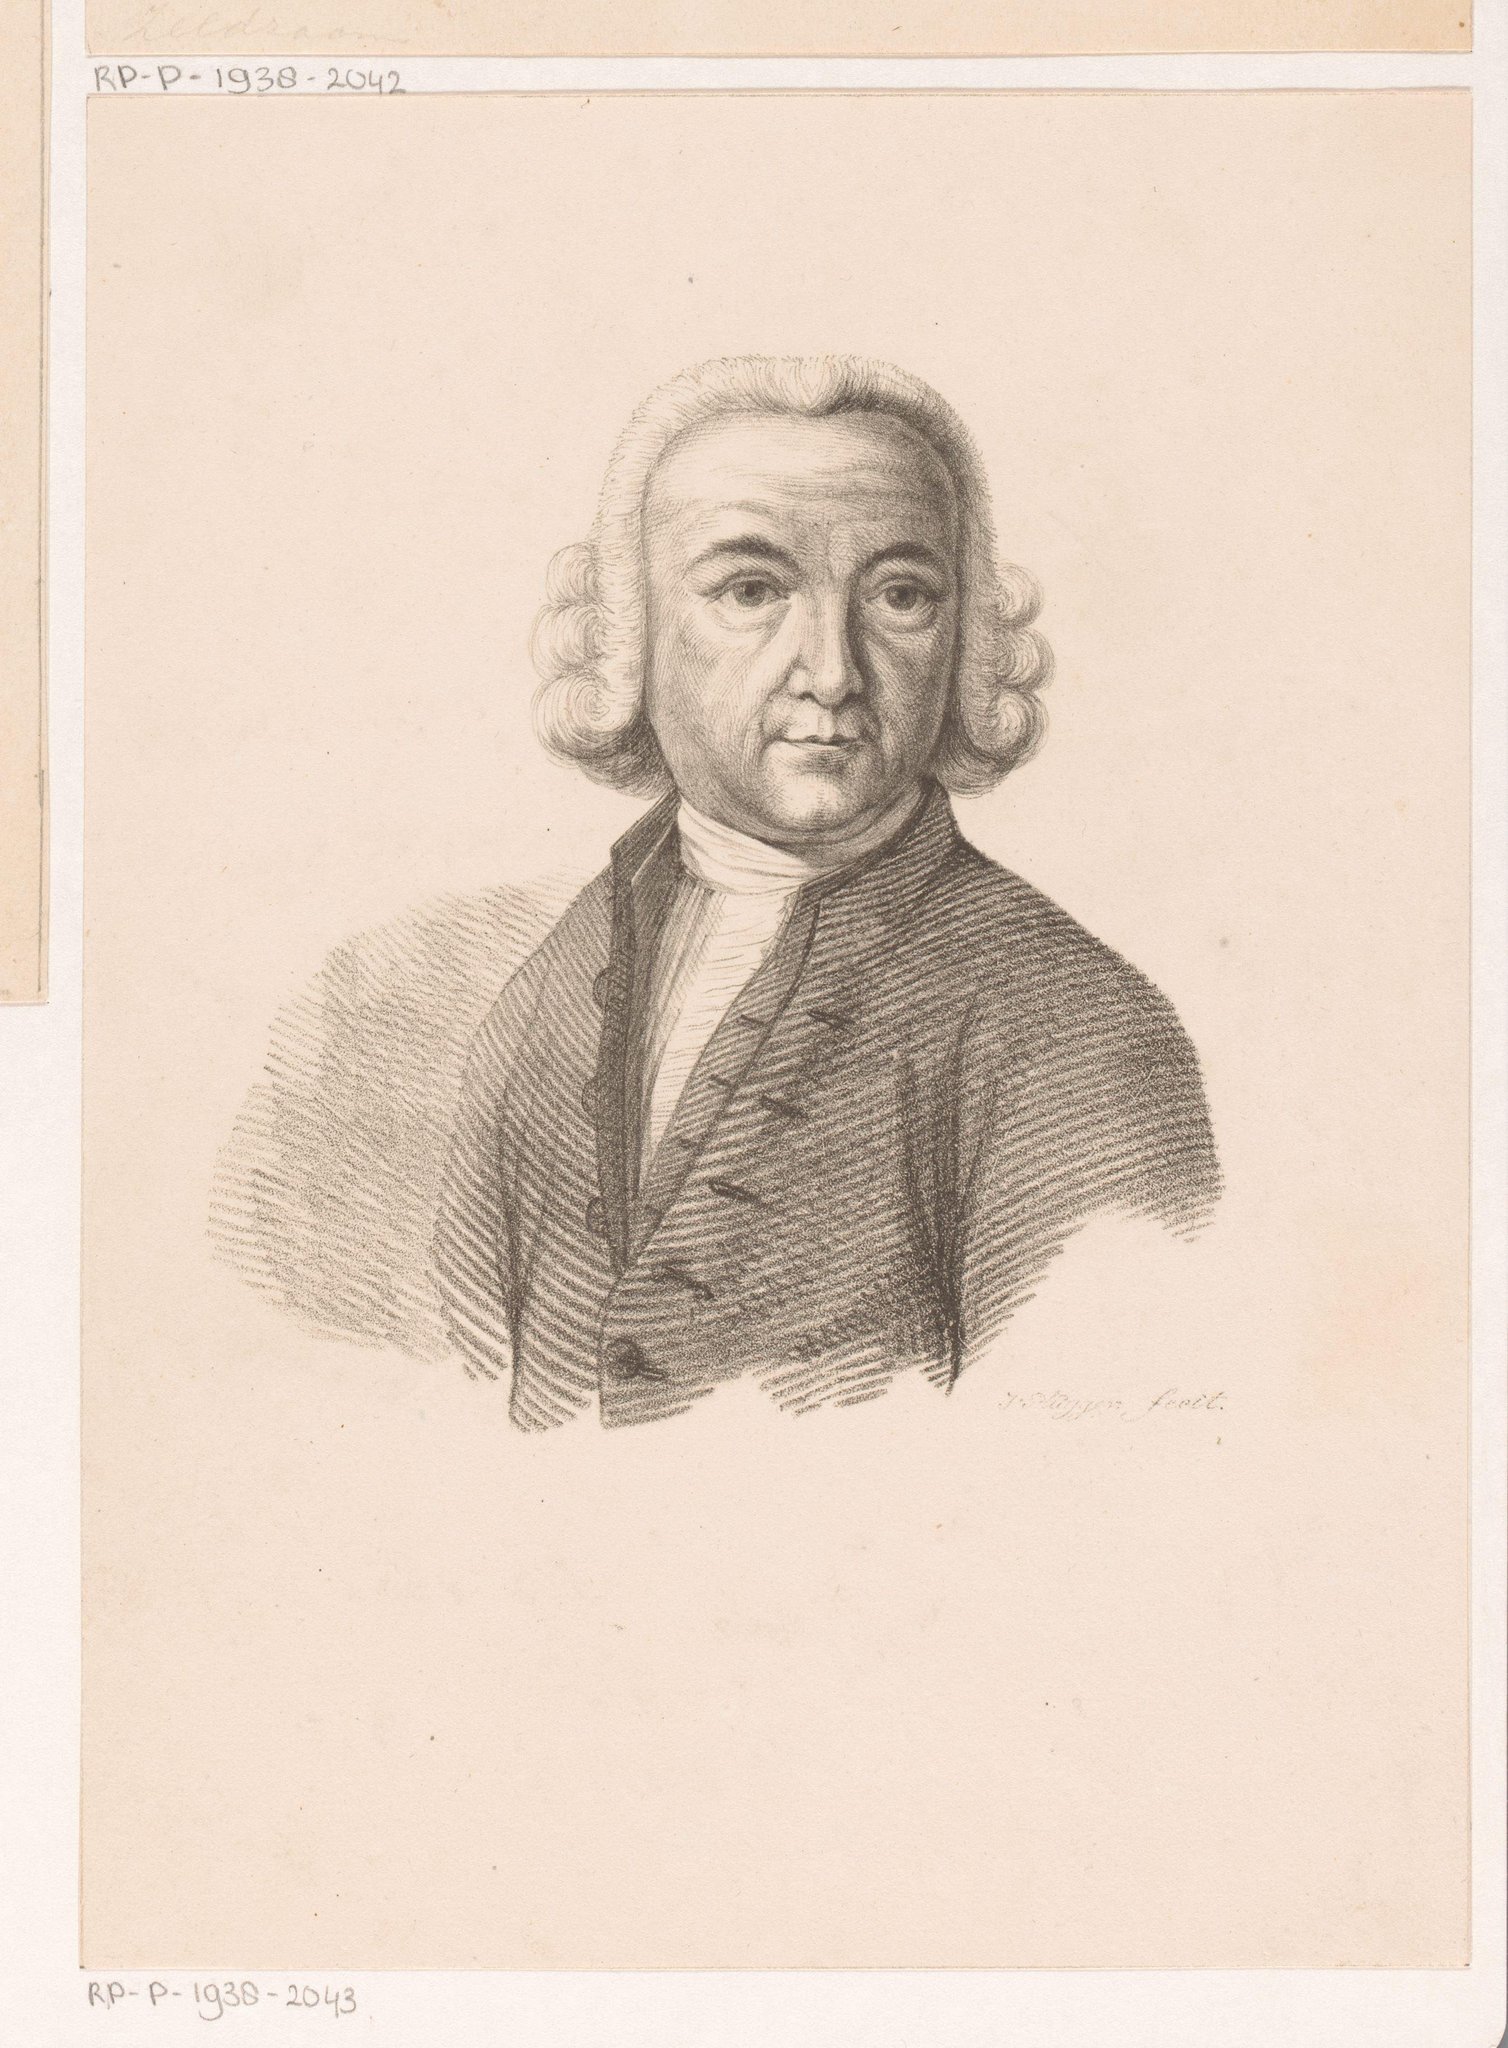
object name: print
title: Portret van Jean Henri van Swinden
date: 1822-1853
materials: paper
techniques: lithograph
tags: the hague, amsterdam, physicist, jean henri van swinden, historical persons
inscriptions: collector's mark: Lugt 2228, collector's mark: Lugt 2760